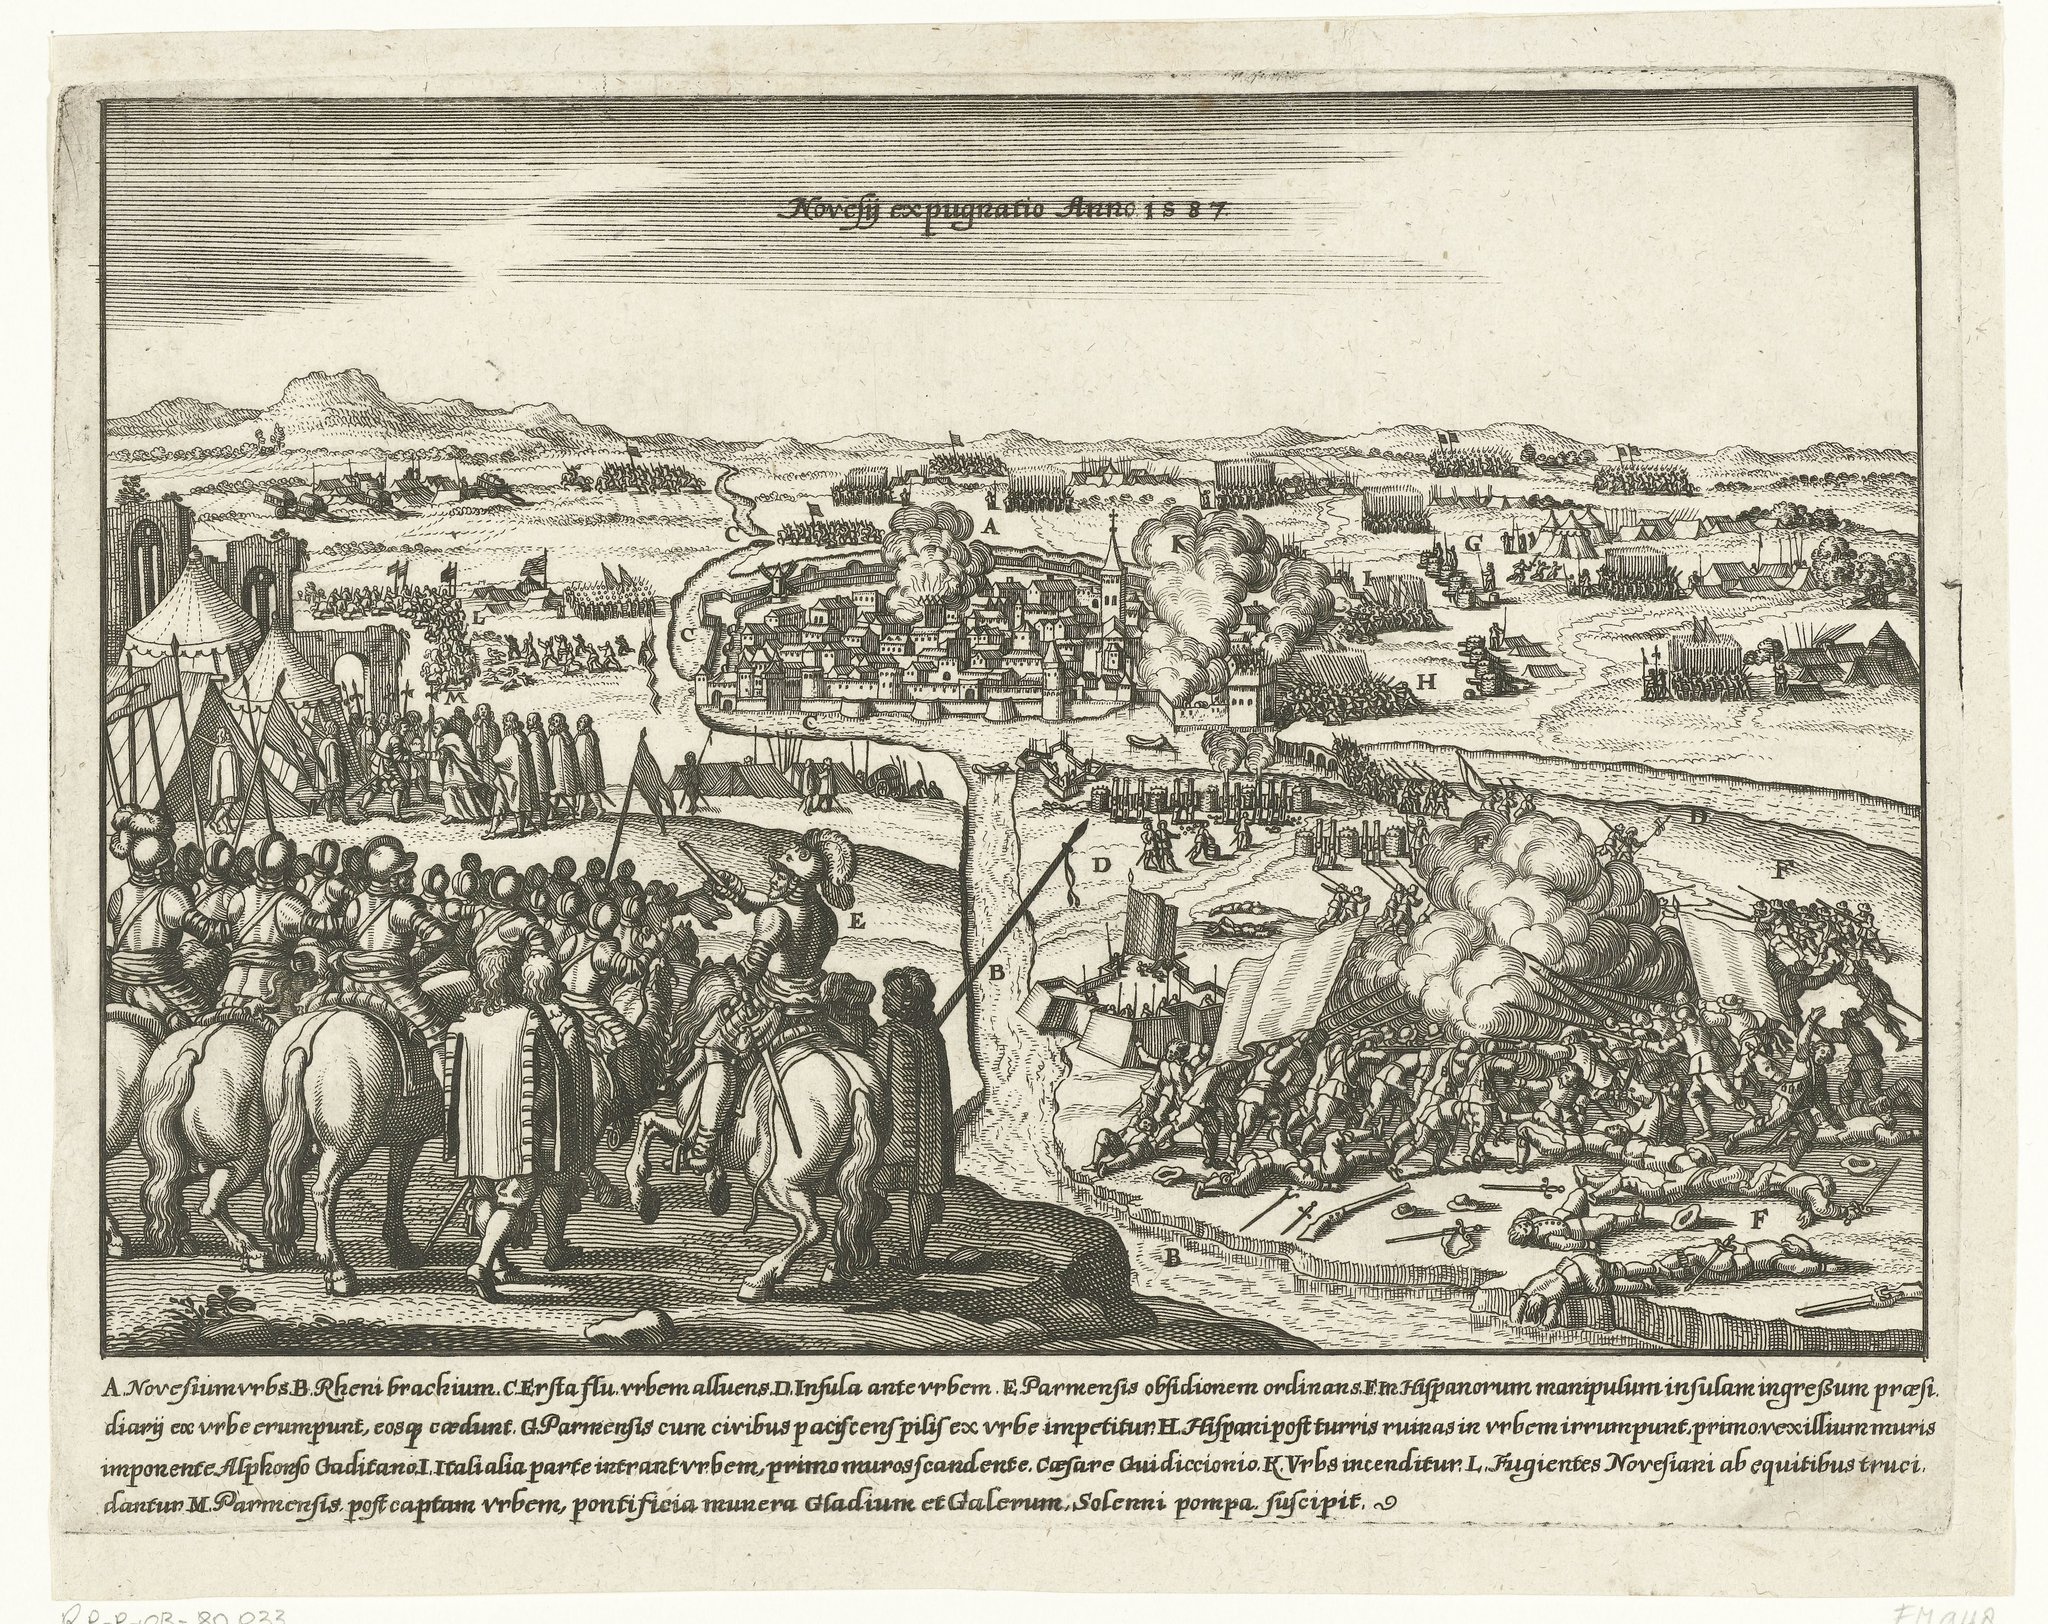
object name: history print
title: Novesij expugnatio Anno 1587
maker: Anonymous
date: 1647-1651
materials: paper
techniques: etching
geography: rome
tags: rome, alessandro farnese (landvoogd van de nederlanden en hertog van parma en piacenza), capture of city (after the siege)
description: Inname en plundering van Neuss door het leger van Parma, 26 juli 1586. Op de voorgrond schermutselingen en de belegerende troepen. De stad wordt ingenomen en in brand gezet. Linksvoor de hertog van Parma te paard. In het onderschrift de titel en de legenda A-M in het Frans.